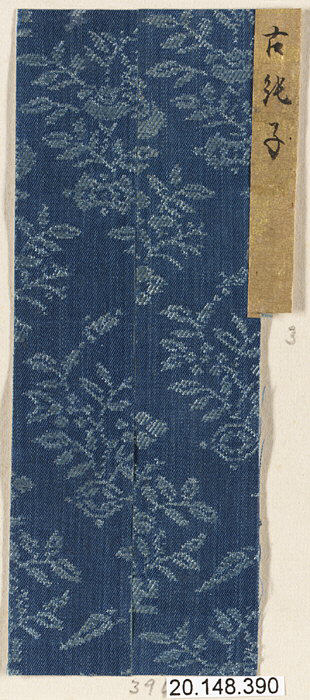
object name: piece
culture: japanese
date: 1601-1700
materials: silk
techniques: compound weave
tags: flowers,leaves